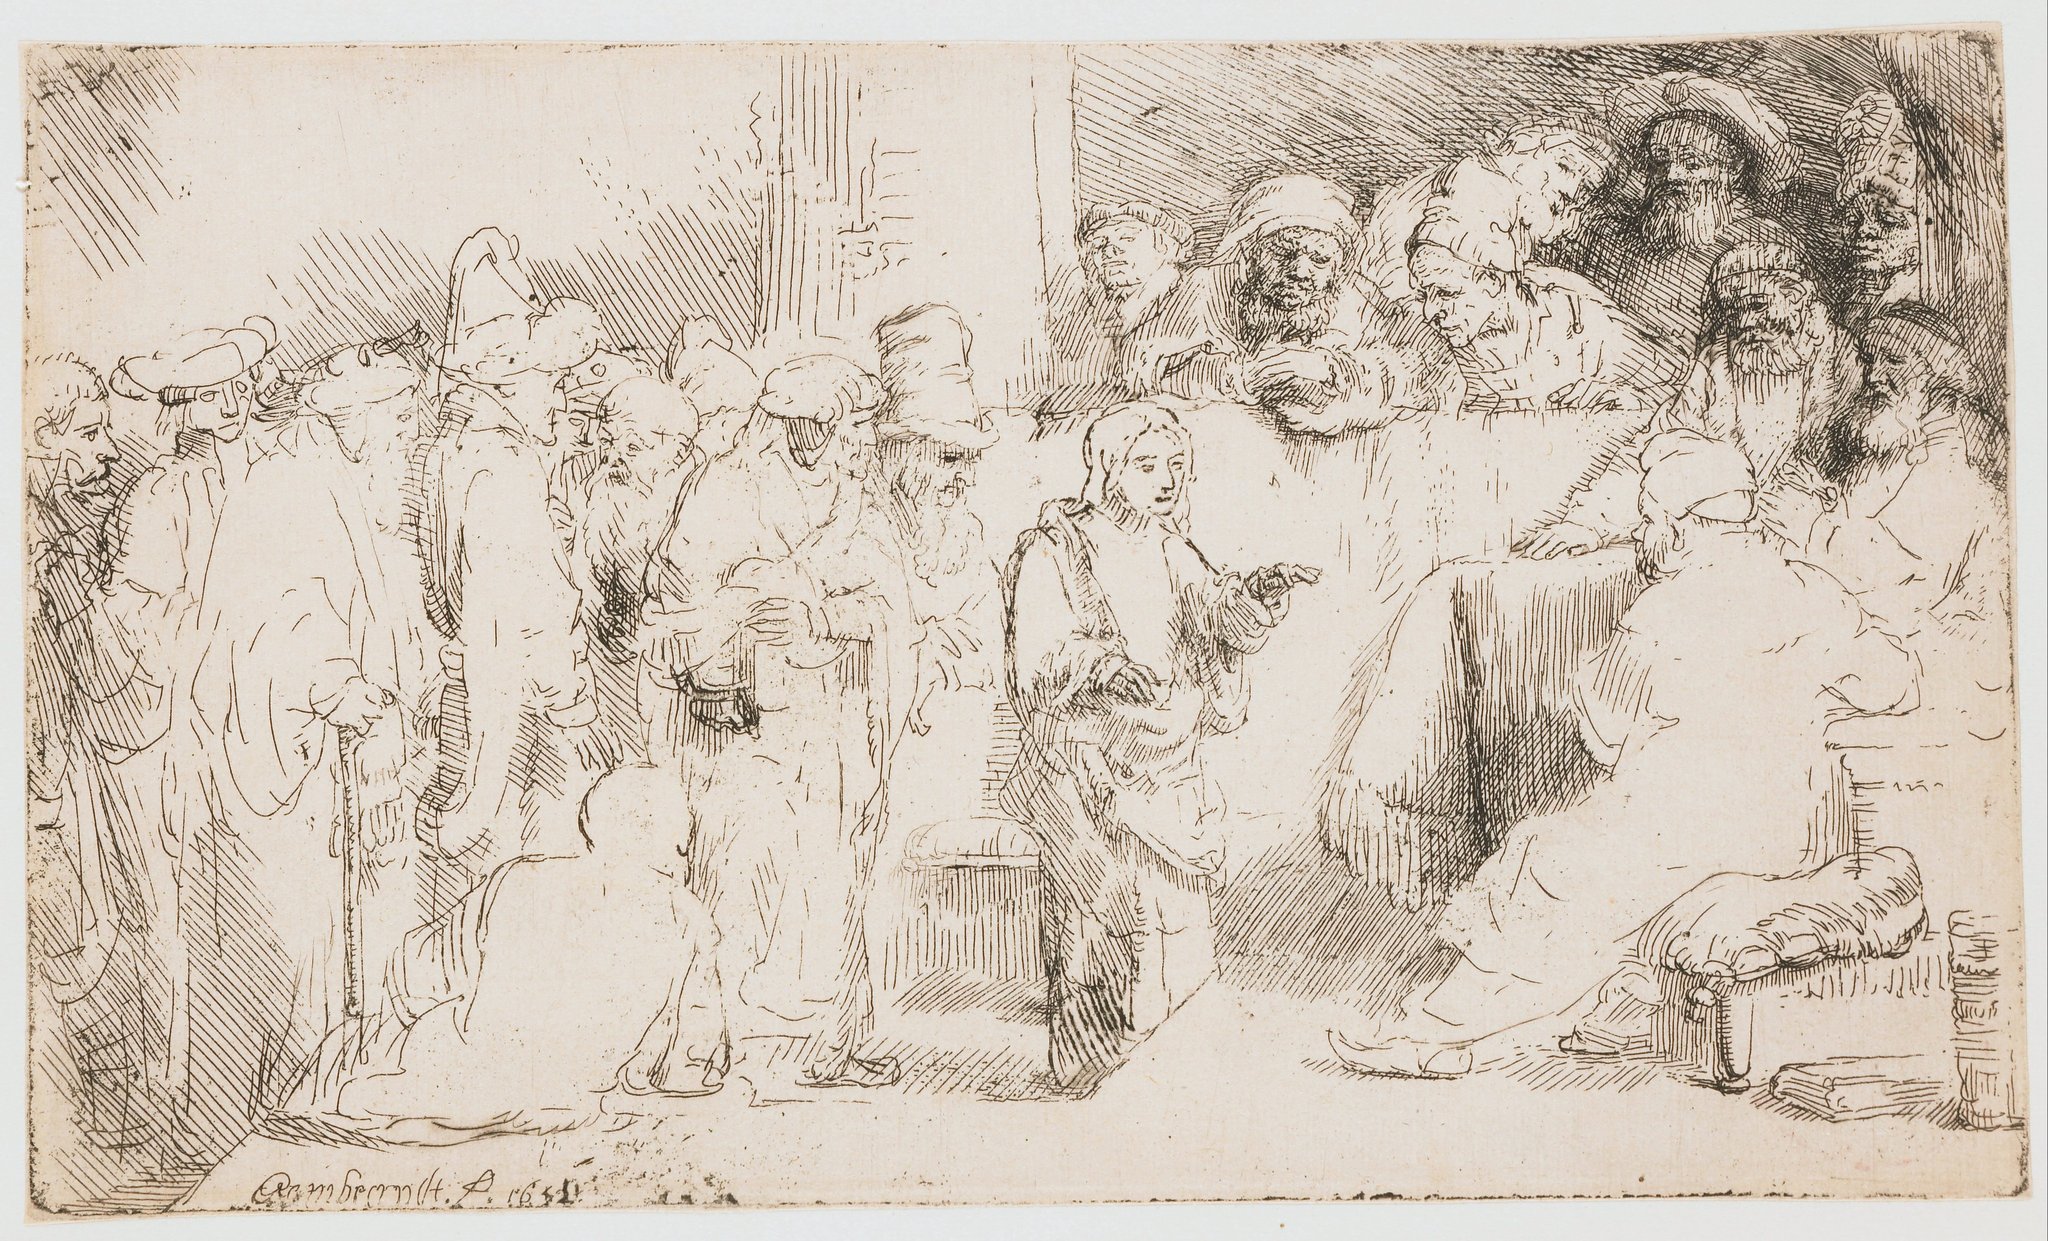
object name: print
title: Christ disputing with the Doctors: a sketch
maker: rembrandt van rijn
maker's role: draughtsman, painter, print maker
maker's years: 1606-1669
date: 1652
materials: paper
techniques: drypoint, etching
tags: christ explaining his doctrine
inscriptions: signature and date: ‘Rembrandt.f.1654’, collector's mark: Lugt 240